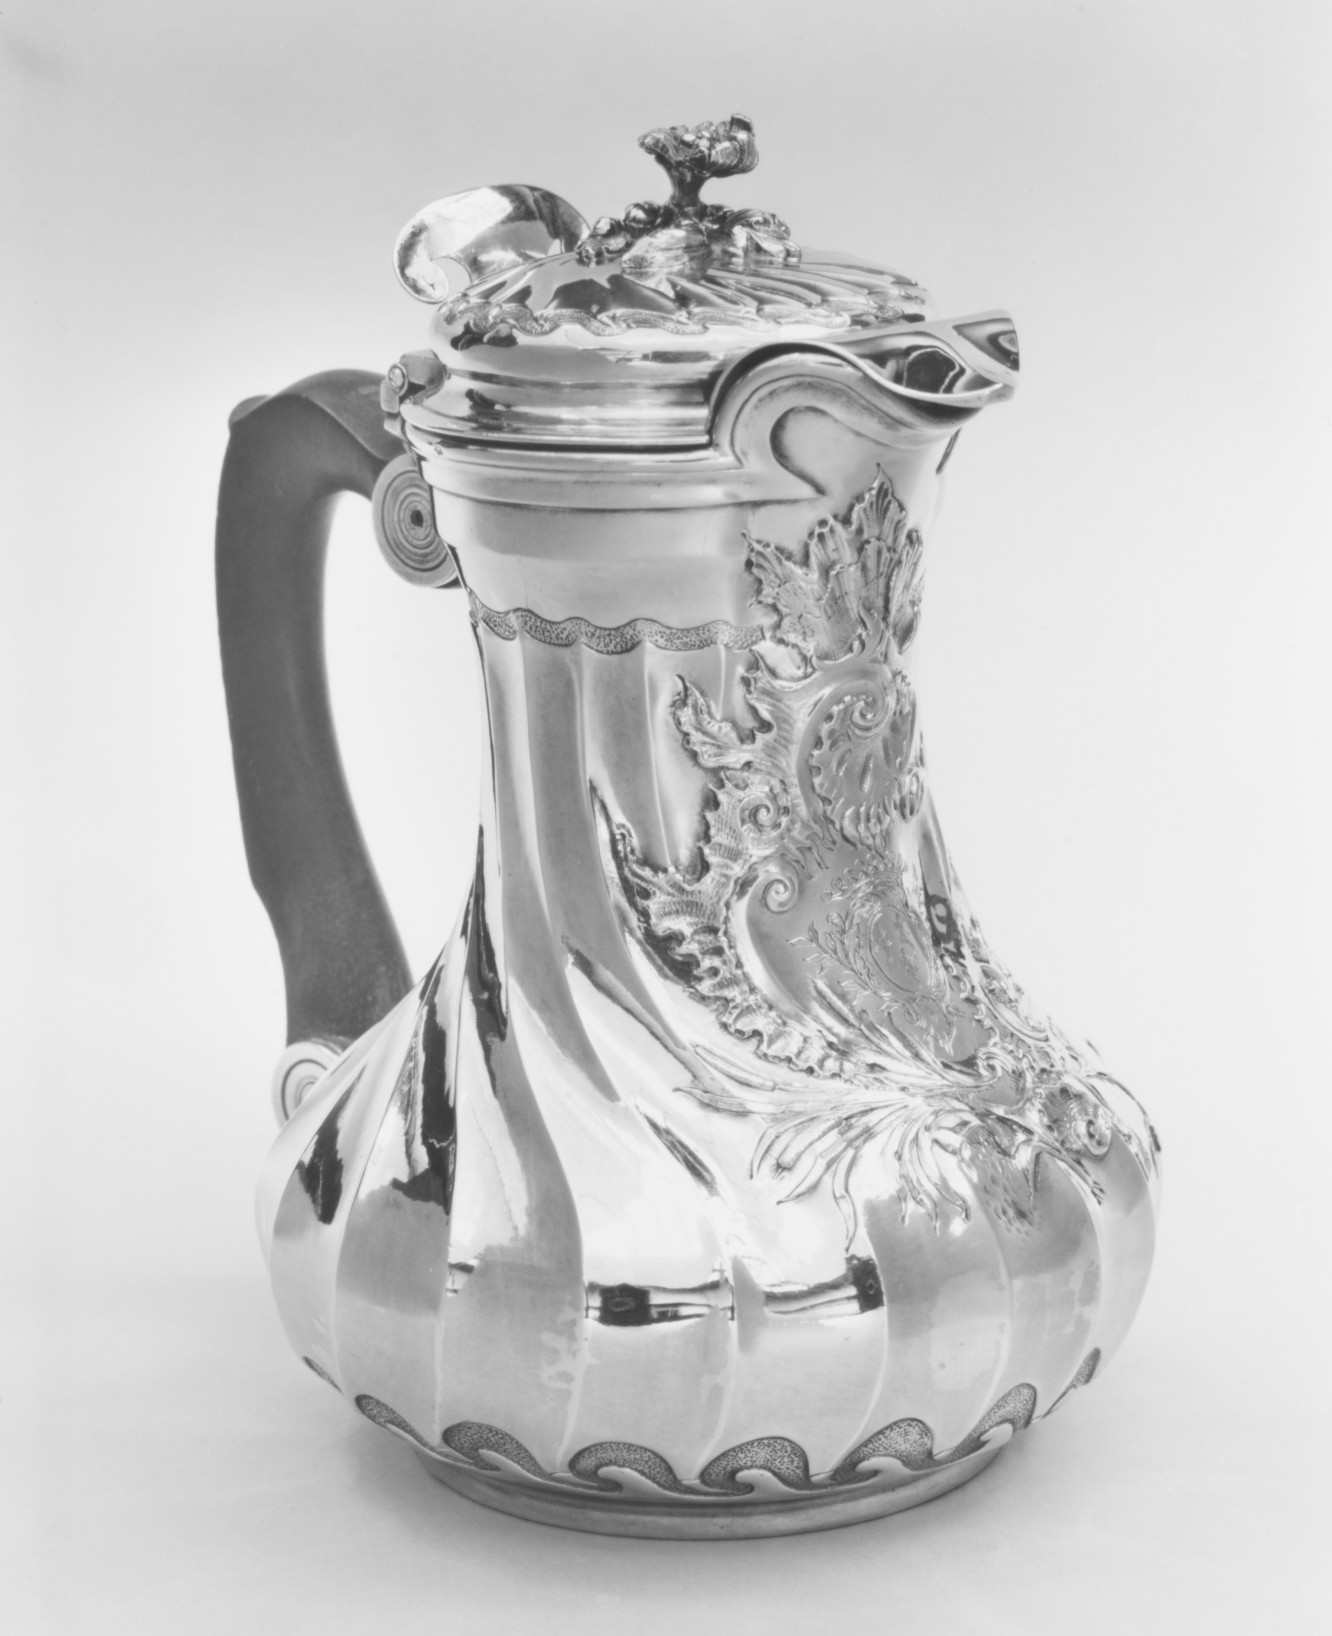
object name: coffeepot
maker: guillaume ledoux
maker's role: maker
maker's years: 1651-1751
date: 1747-1748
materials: wood, silver